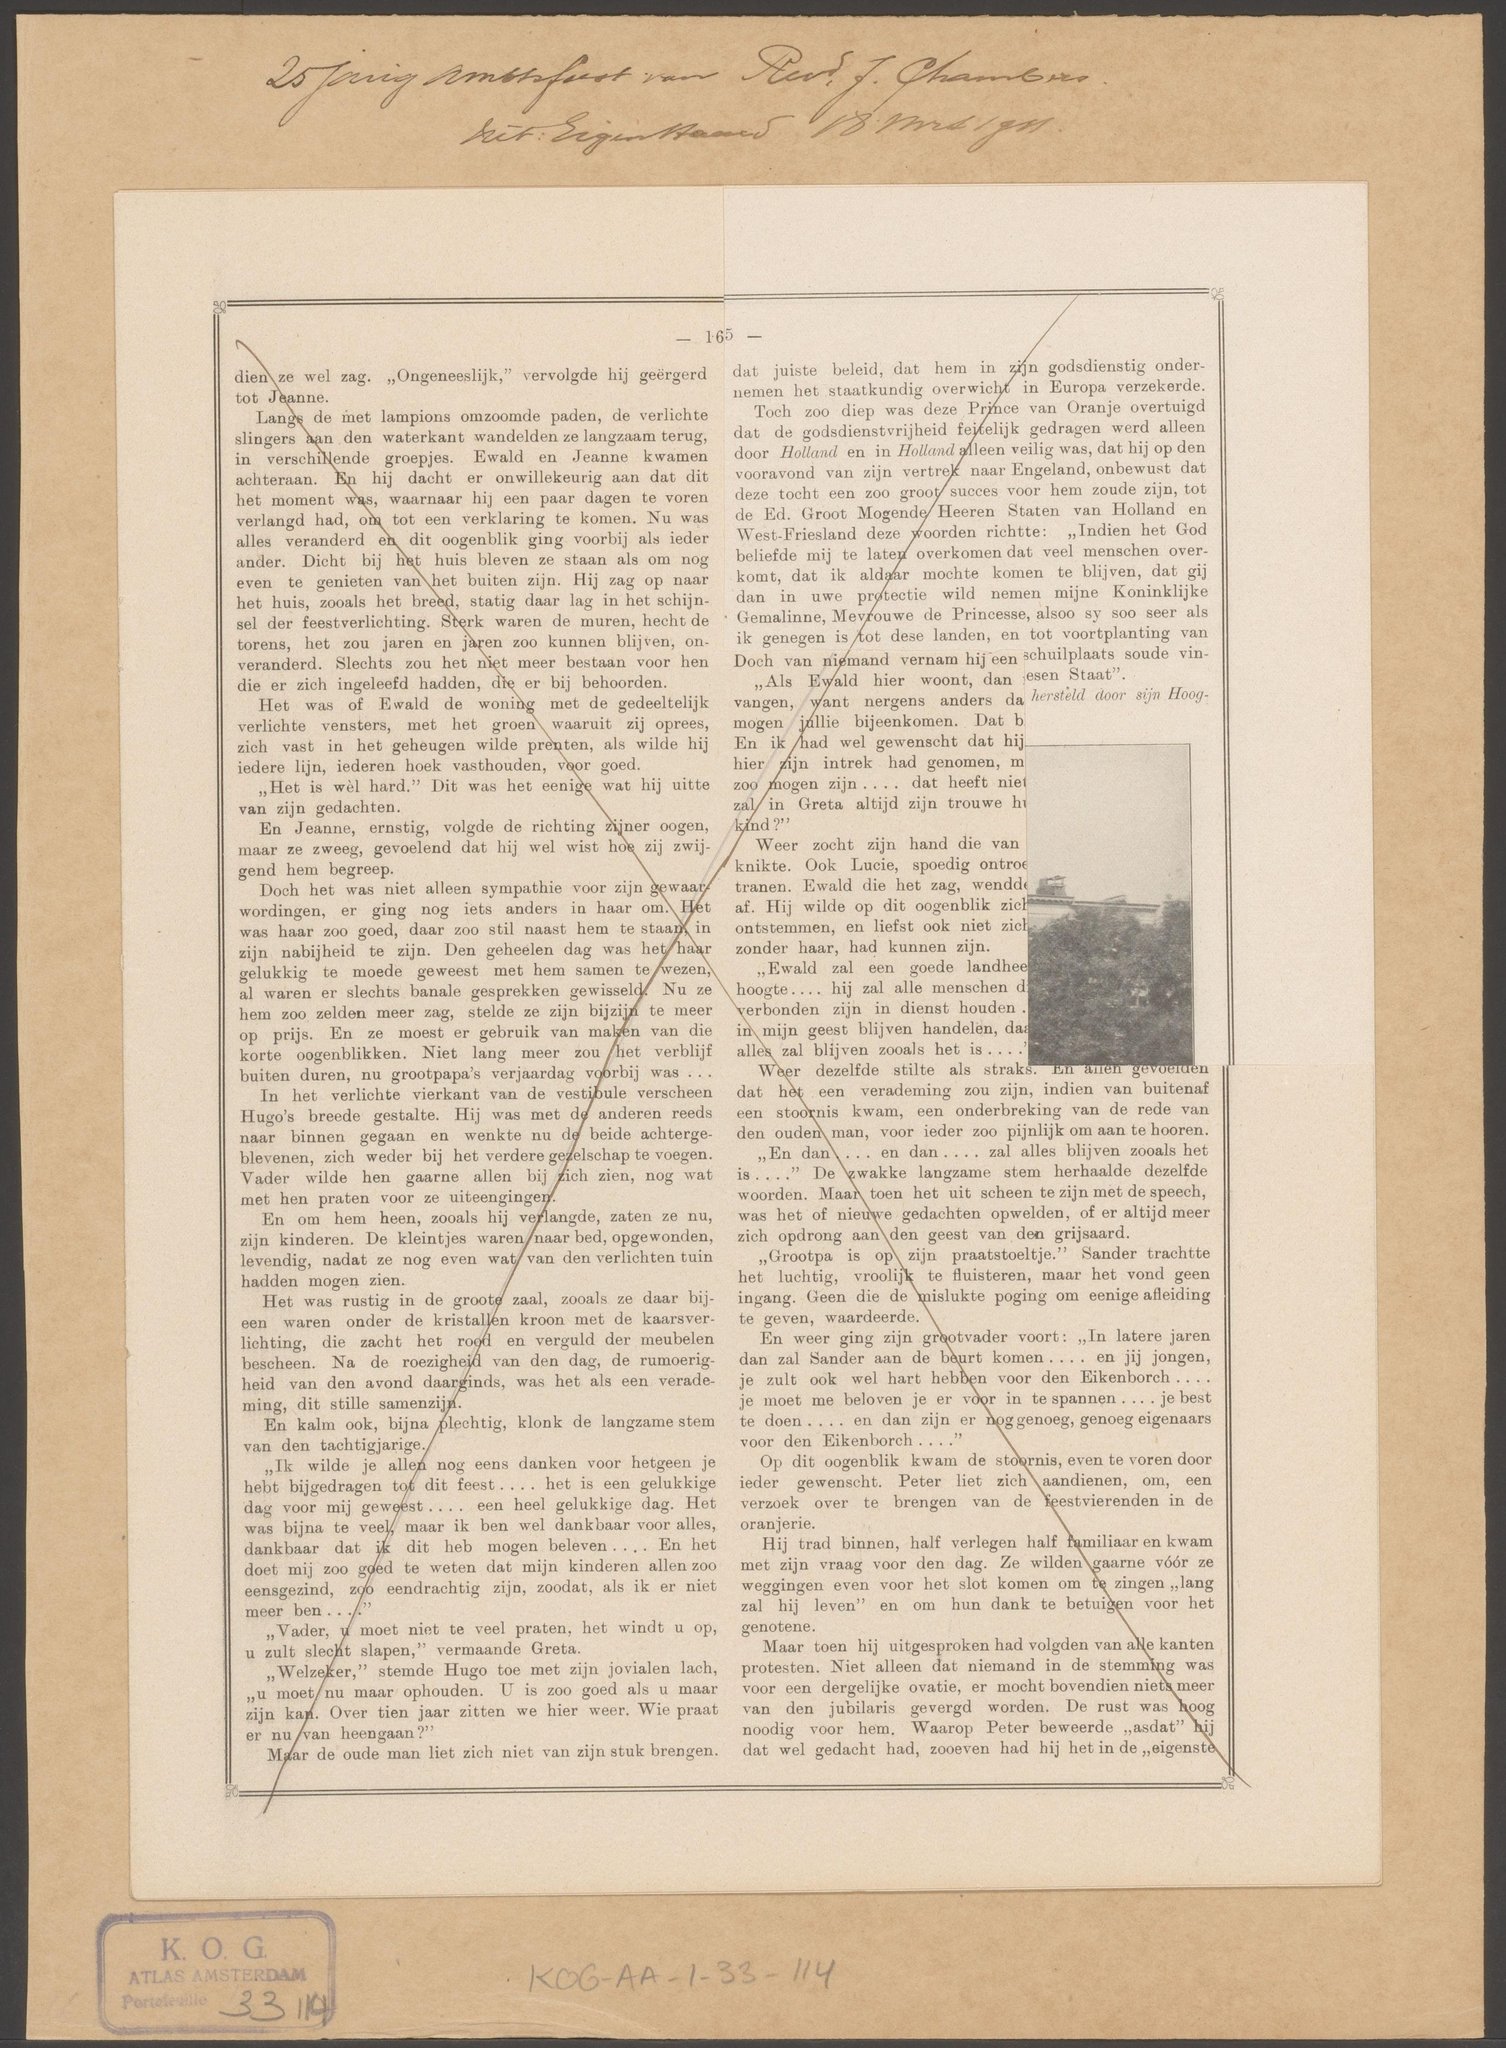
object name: photomechanical print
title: Het Vijf-en-Twintigjarig ambtsfeest van Revd. J. Chambers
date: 1911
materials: paper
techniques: letterpress printing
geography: amsterdam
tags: historical persons, church (exterior), interior of church, canals, waters (in city) (+ city(-scape) with figures, staffage)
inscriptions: collector's mark: Lugt 1641b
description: Object bestaat uit drie bladen met fotomechanische afdrukken op pagina 164-167. Onderwerpsrubriek binnen de Atlas Amsterdam: Kerkwezen: Hervormde Gemeente: Gebouwen diverse gemeenten: Episcopale Gemeente.